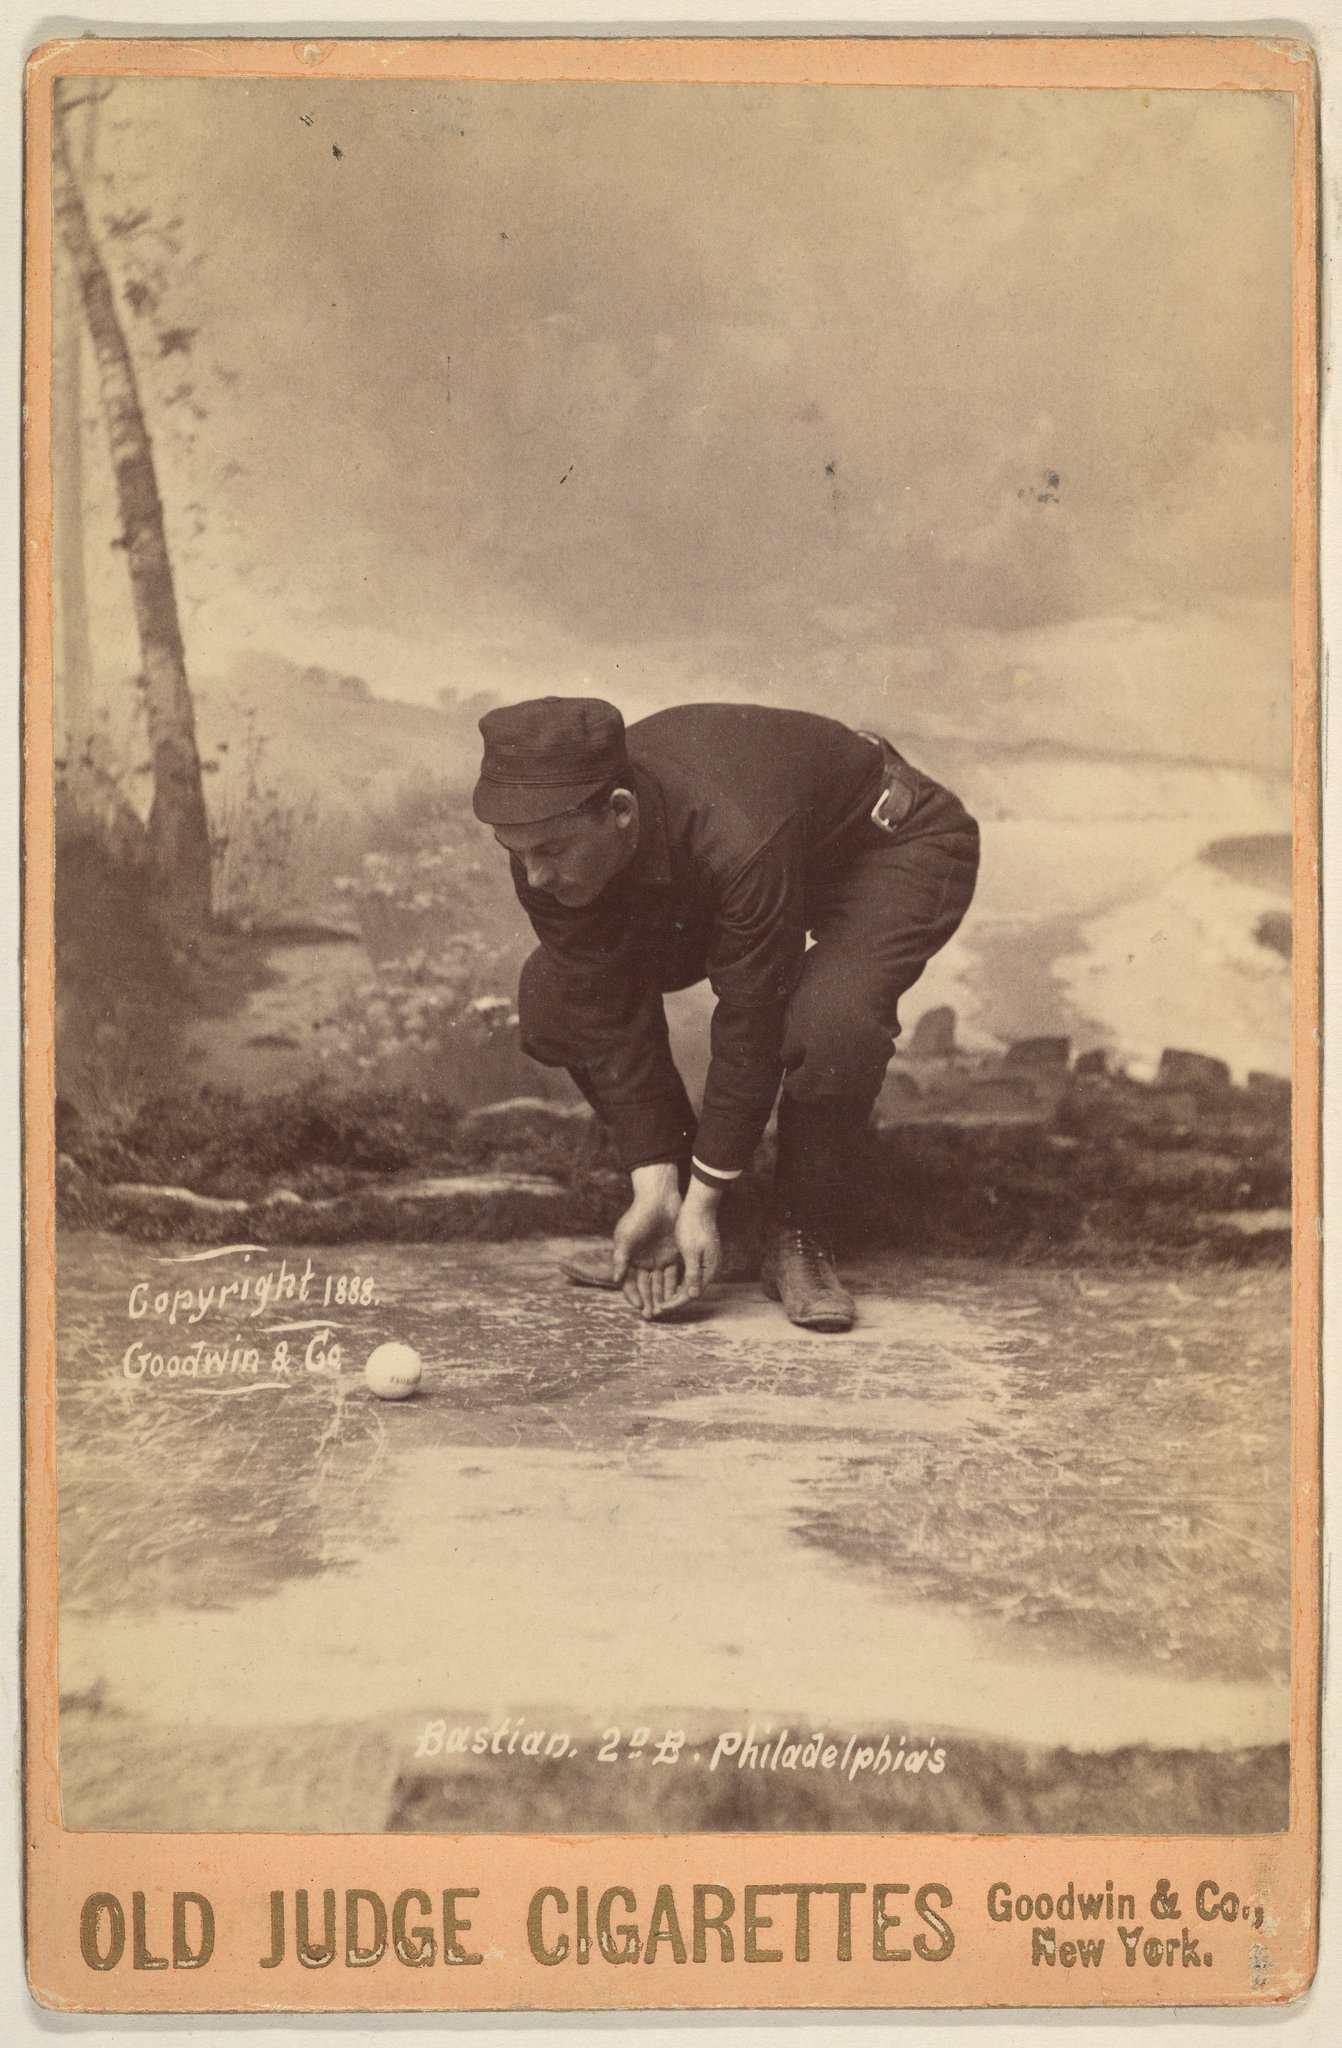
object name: baseball card, photograph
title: Bastian, 2nd Base, Philadelphia, from the series Old Judge Cigarettes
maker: goodwin & company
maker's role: publisher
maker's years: 1850-1950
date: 1888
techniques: albumen silver print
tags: men,baseball,athletes